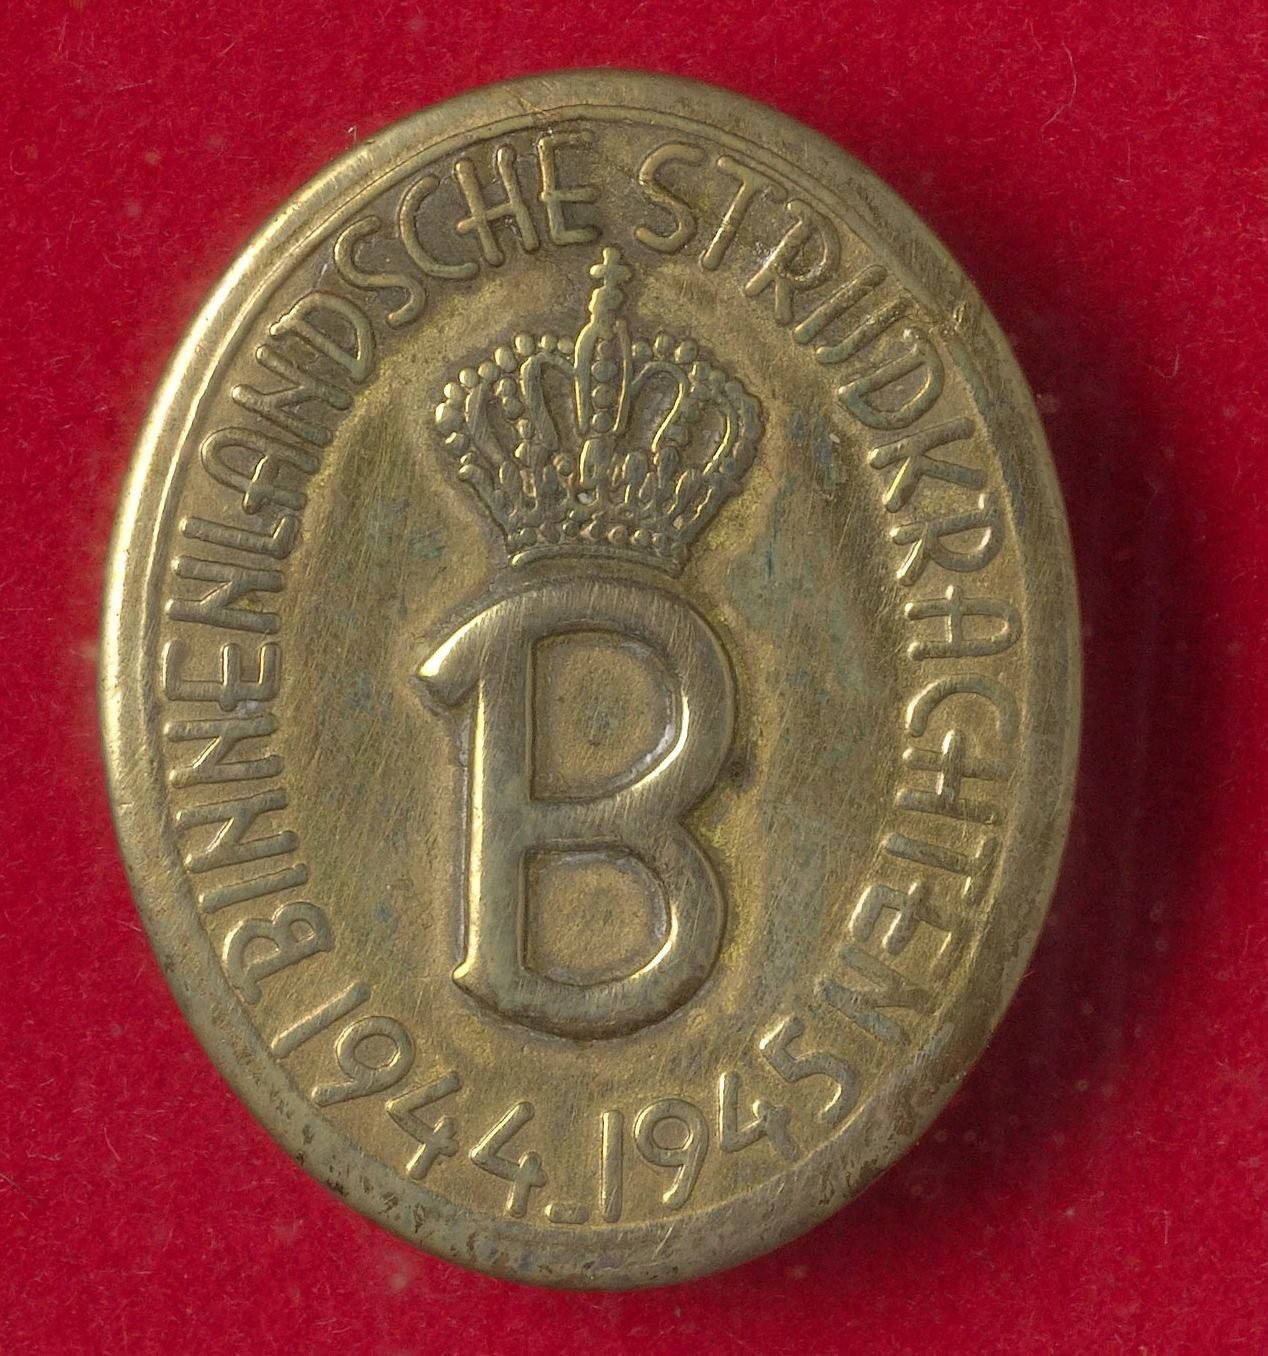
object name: pin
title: Verzets-speld Binnenlandse Strijdkrachten 1944-1945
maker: Anonymous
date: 1945-1946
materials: metal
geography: netherlands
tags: amsterdam, tonny van renterghem, netherlands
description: Verzets-speld Binnenlandse Strijdkrachten 1944-1945. B met kroon. Ovaal, koperkleurig.